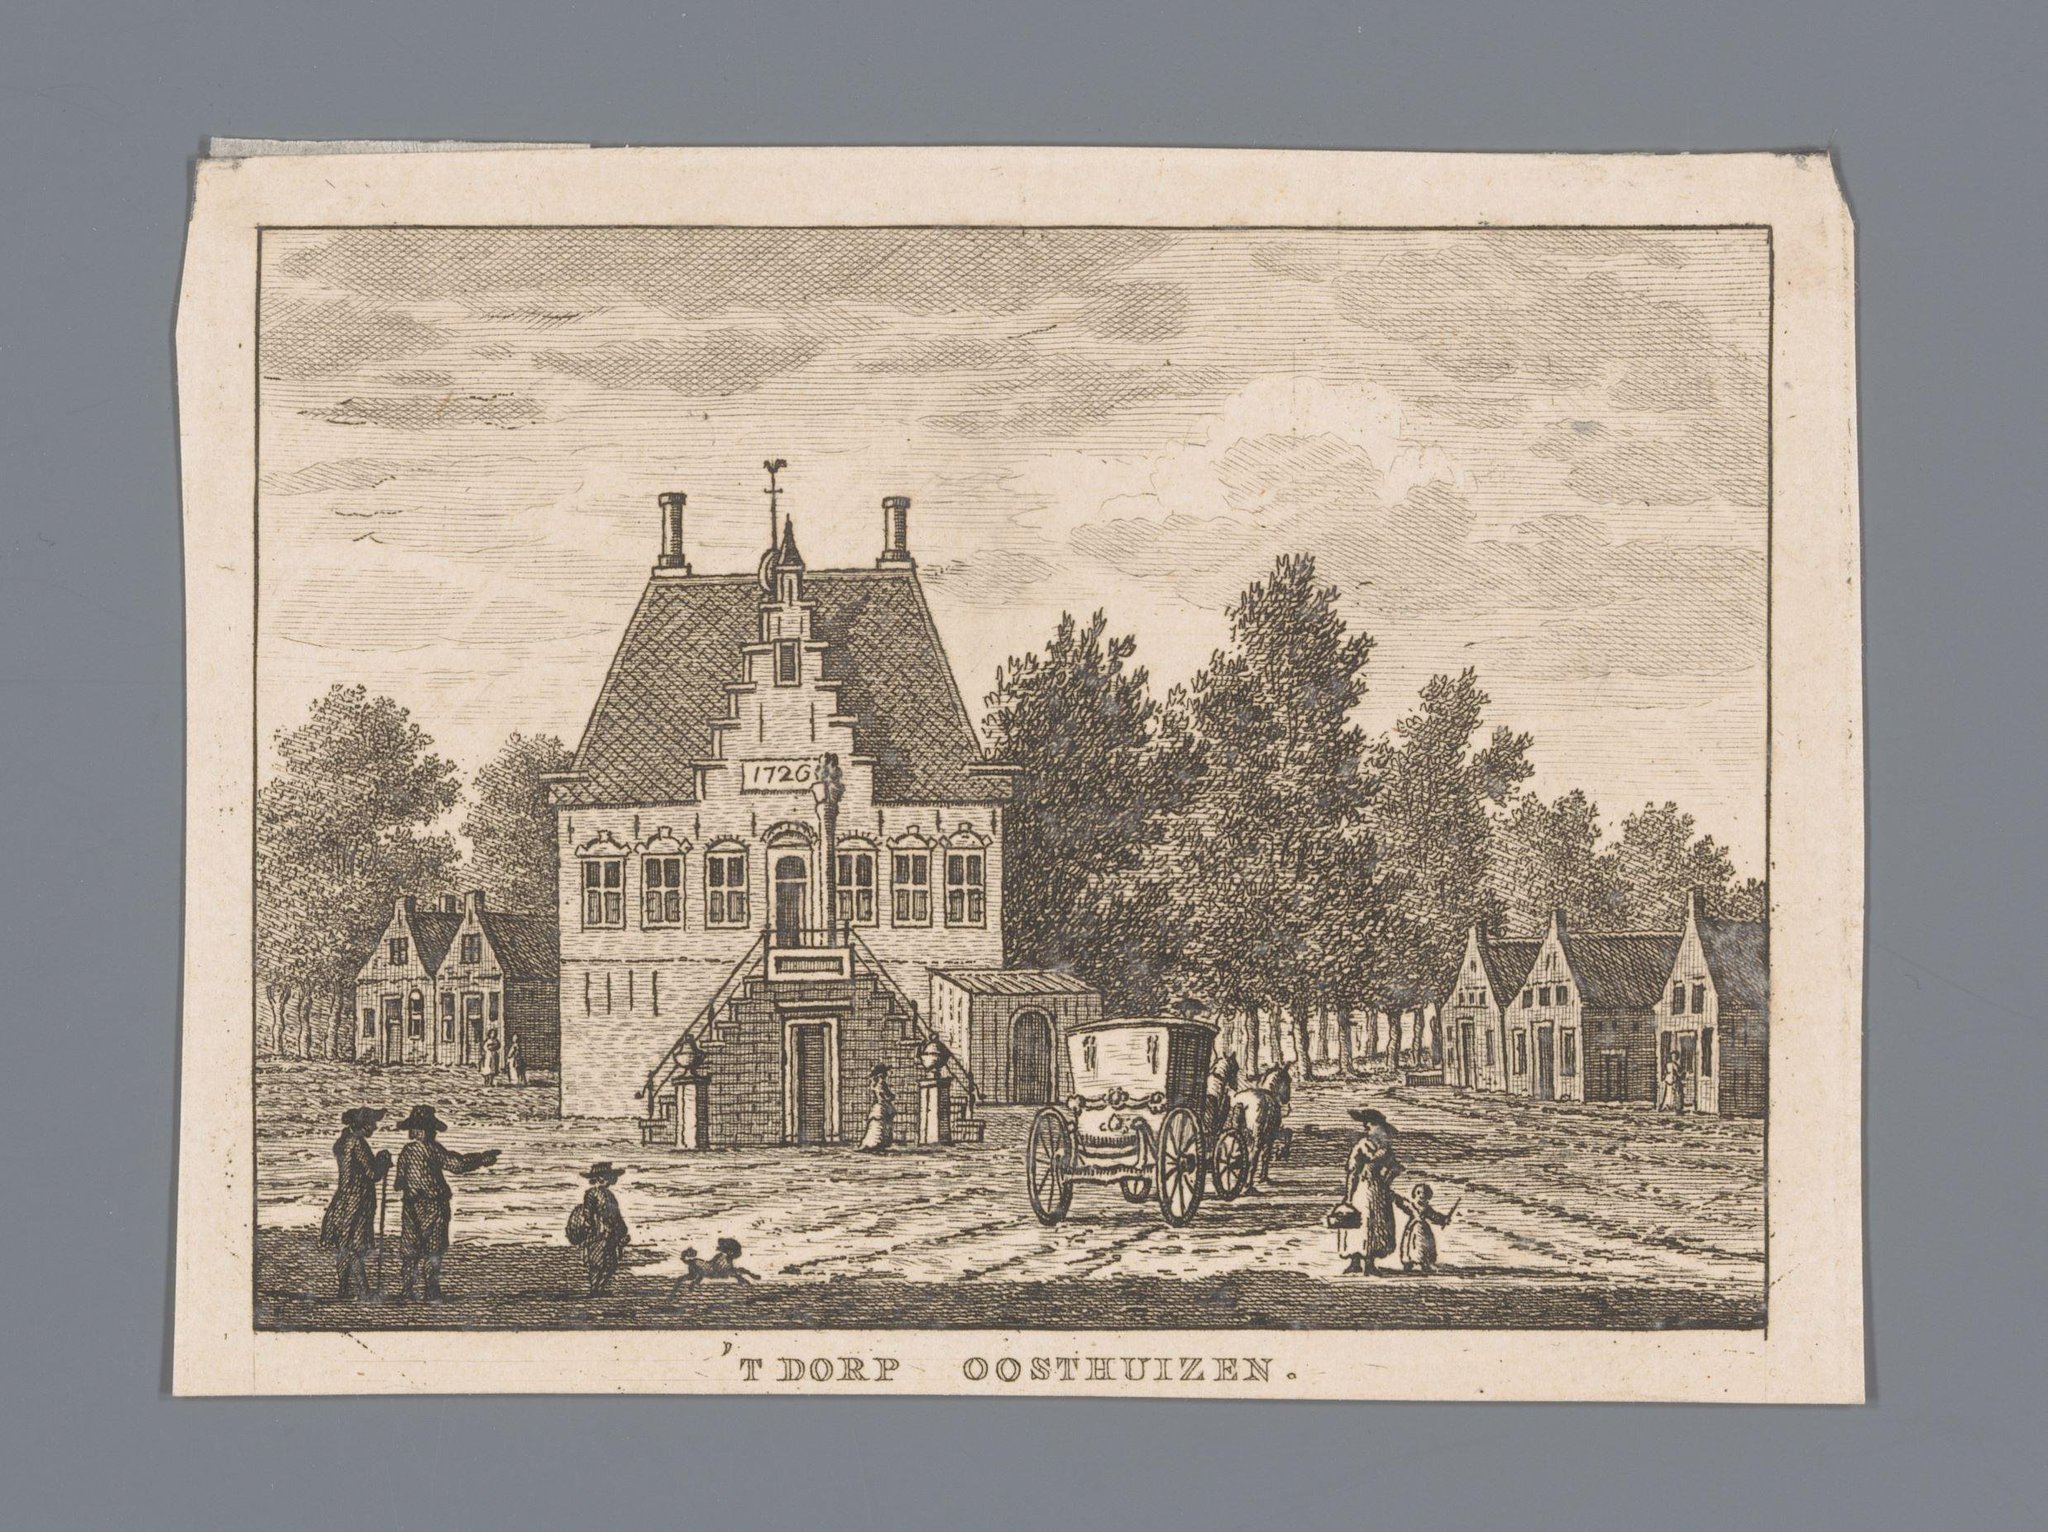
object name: print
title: Gezicht op Oosthuizen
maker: carel frederik bendorp (i)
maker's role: print maker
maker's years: 1736-1814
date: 1786-1792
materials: paper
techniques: etching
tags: city-view, and landscape with man-made constructions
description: Prent uit: Vaderlandsche gezichten, of afbeeldingen van den tegenwoordigen staat der Vereenigde Nederlanden (…). Amsterdam: Hendrik Gartman, Willem Vermandel en Jan Willem Smit, 1786-1792. Uitgegeven in afleveringen met ieder een eigen bifolium en inhoudsopgave. Alle prenten in deze publicatie zijn gegraveerd door Carel Frederik Bendorp (I) en, in de meeste gevallen, gebaseerd op tekeningen van Jan Bulthuis.